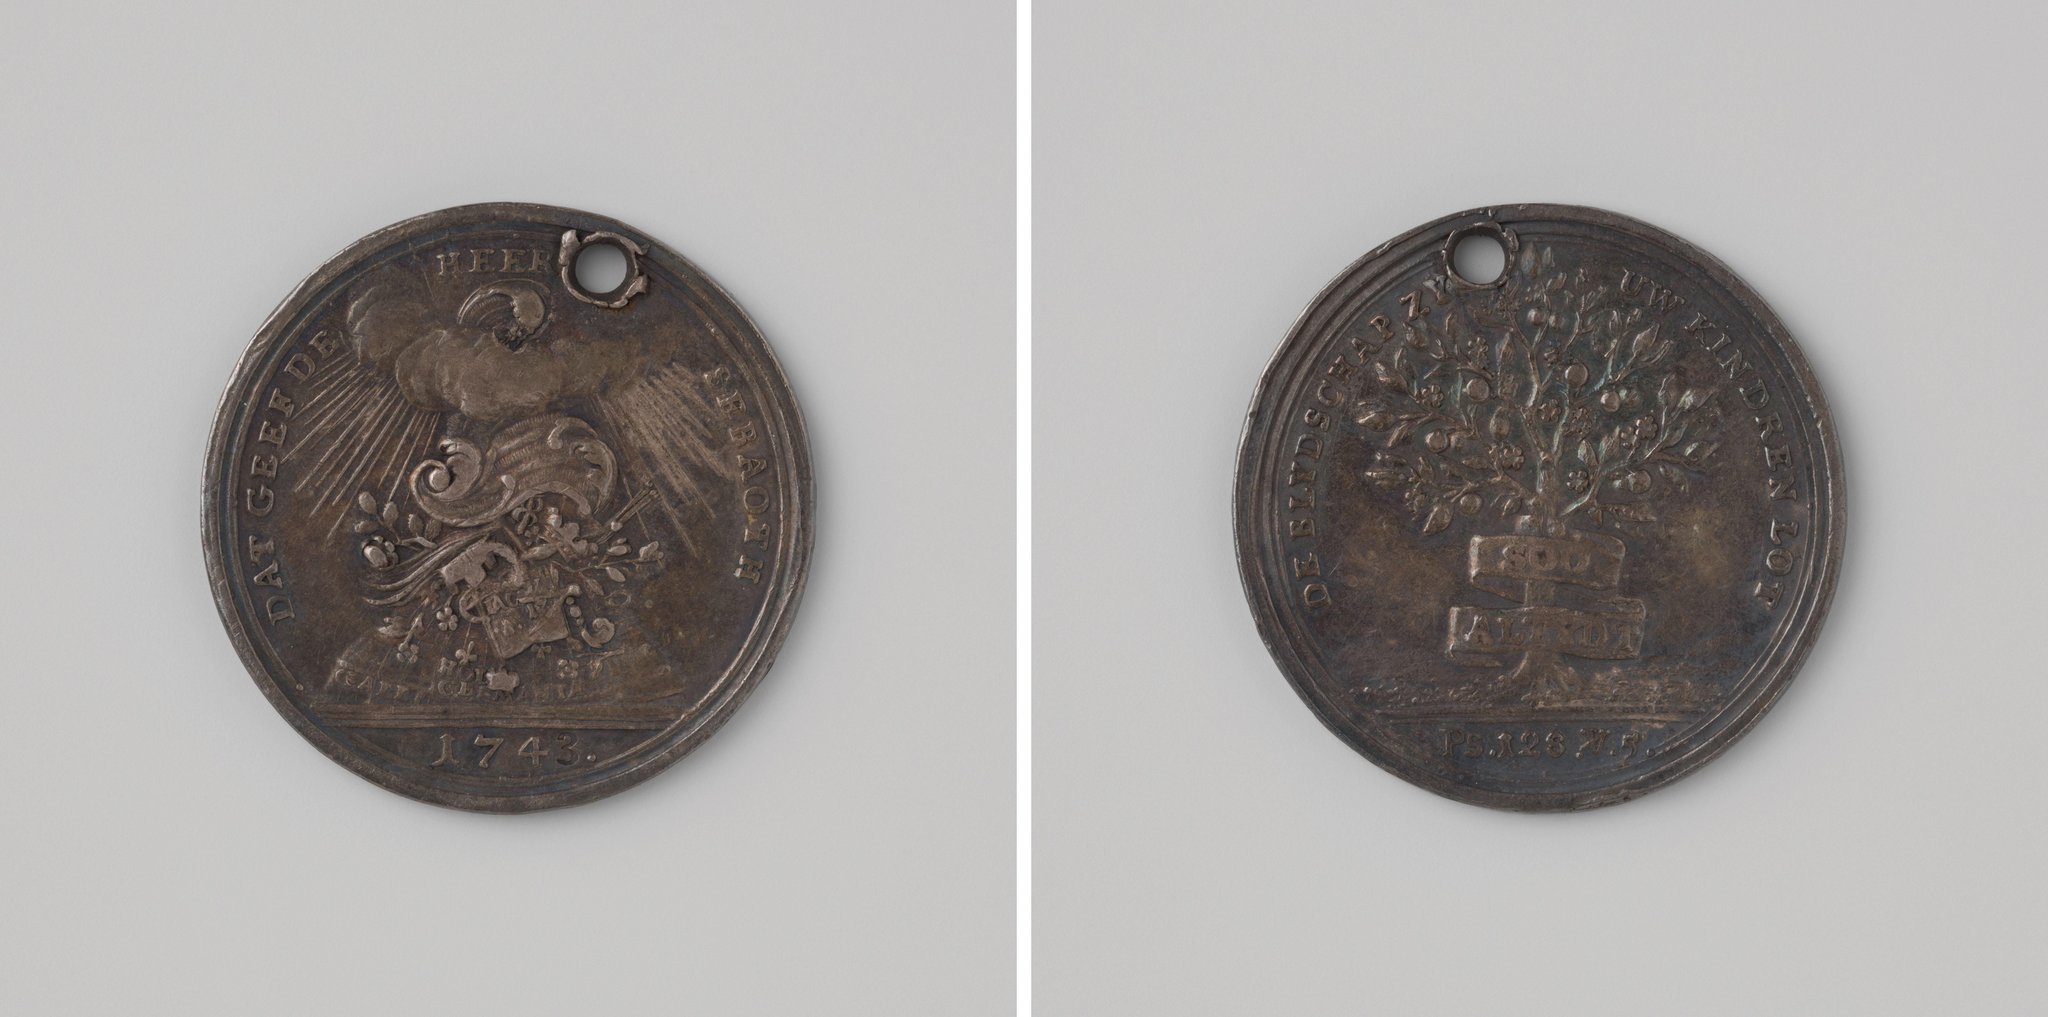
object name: medal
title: Gelegenheidspenning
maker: Anonymous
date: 1743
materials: silver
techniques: engraving, striking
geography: netherlands